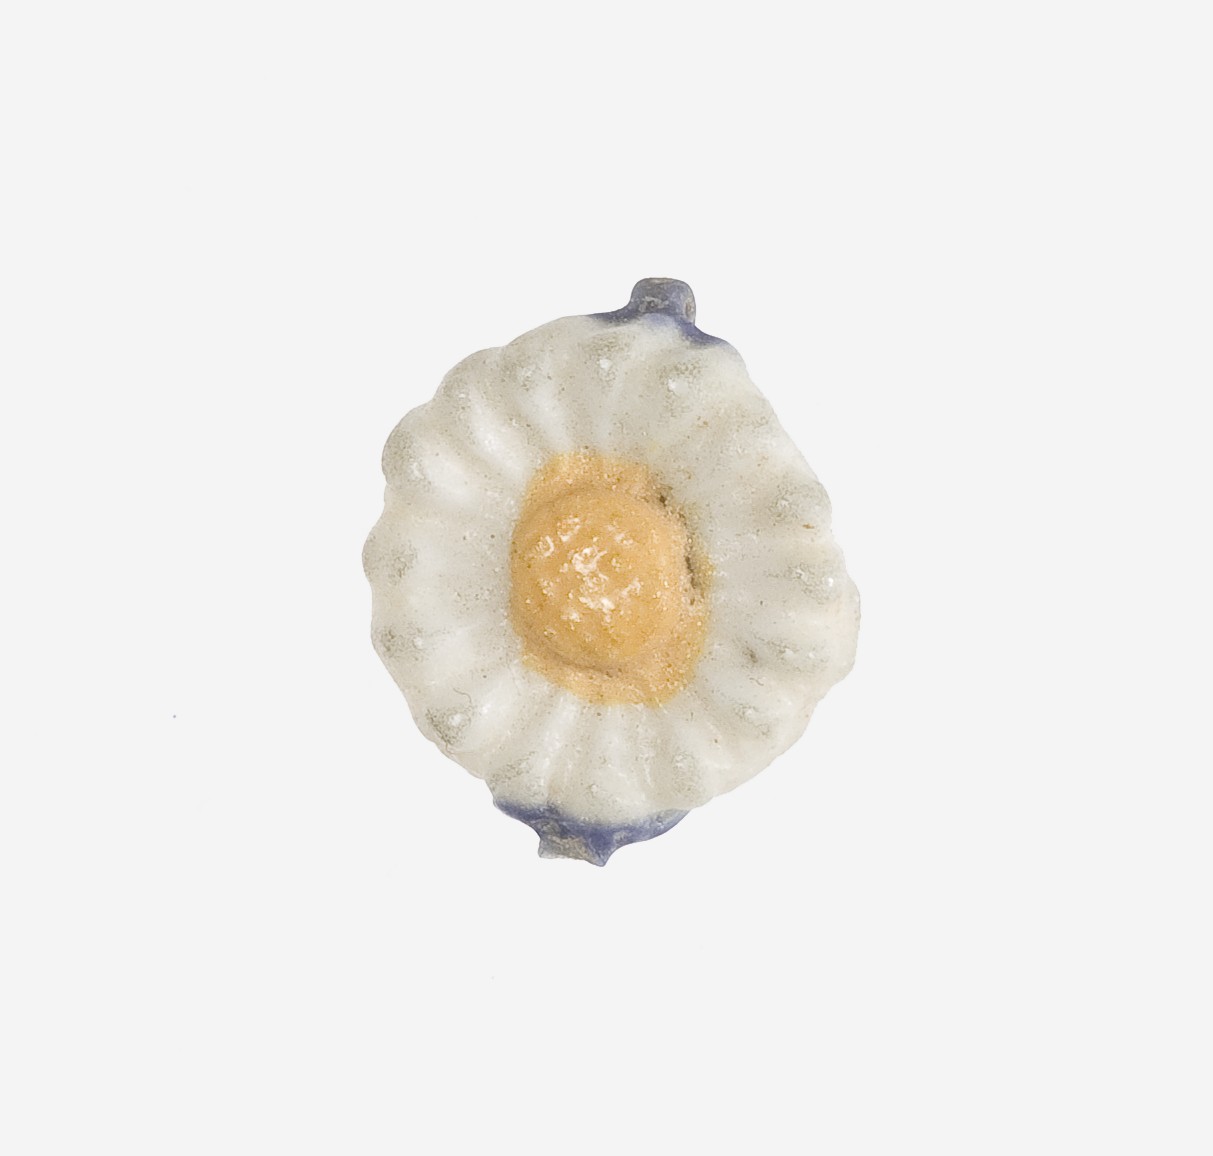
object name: bead, daisy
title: Daisy Bead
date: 1390-1352 BCE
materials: faience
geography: egypt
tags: daisies